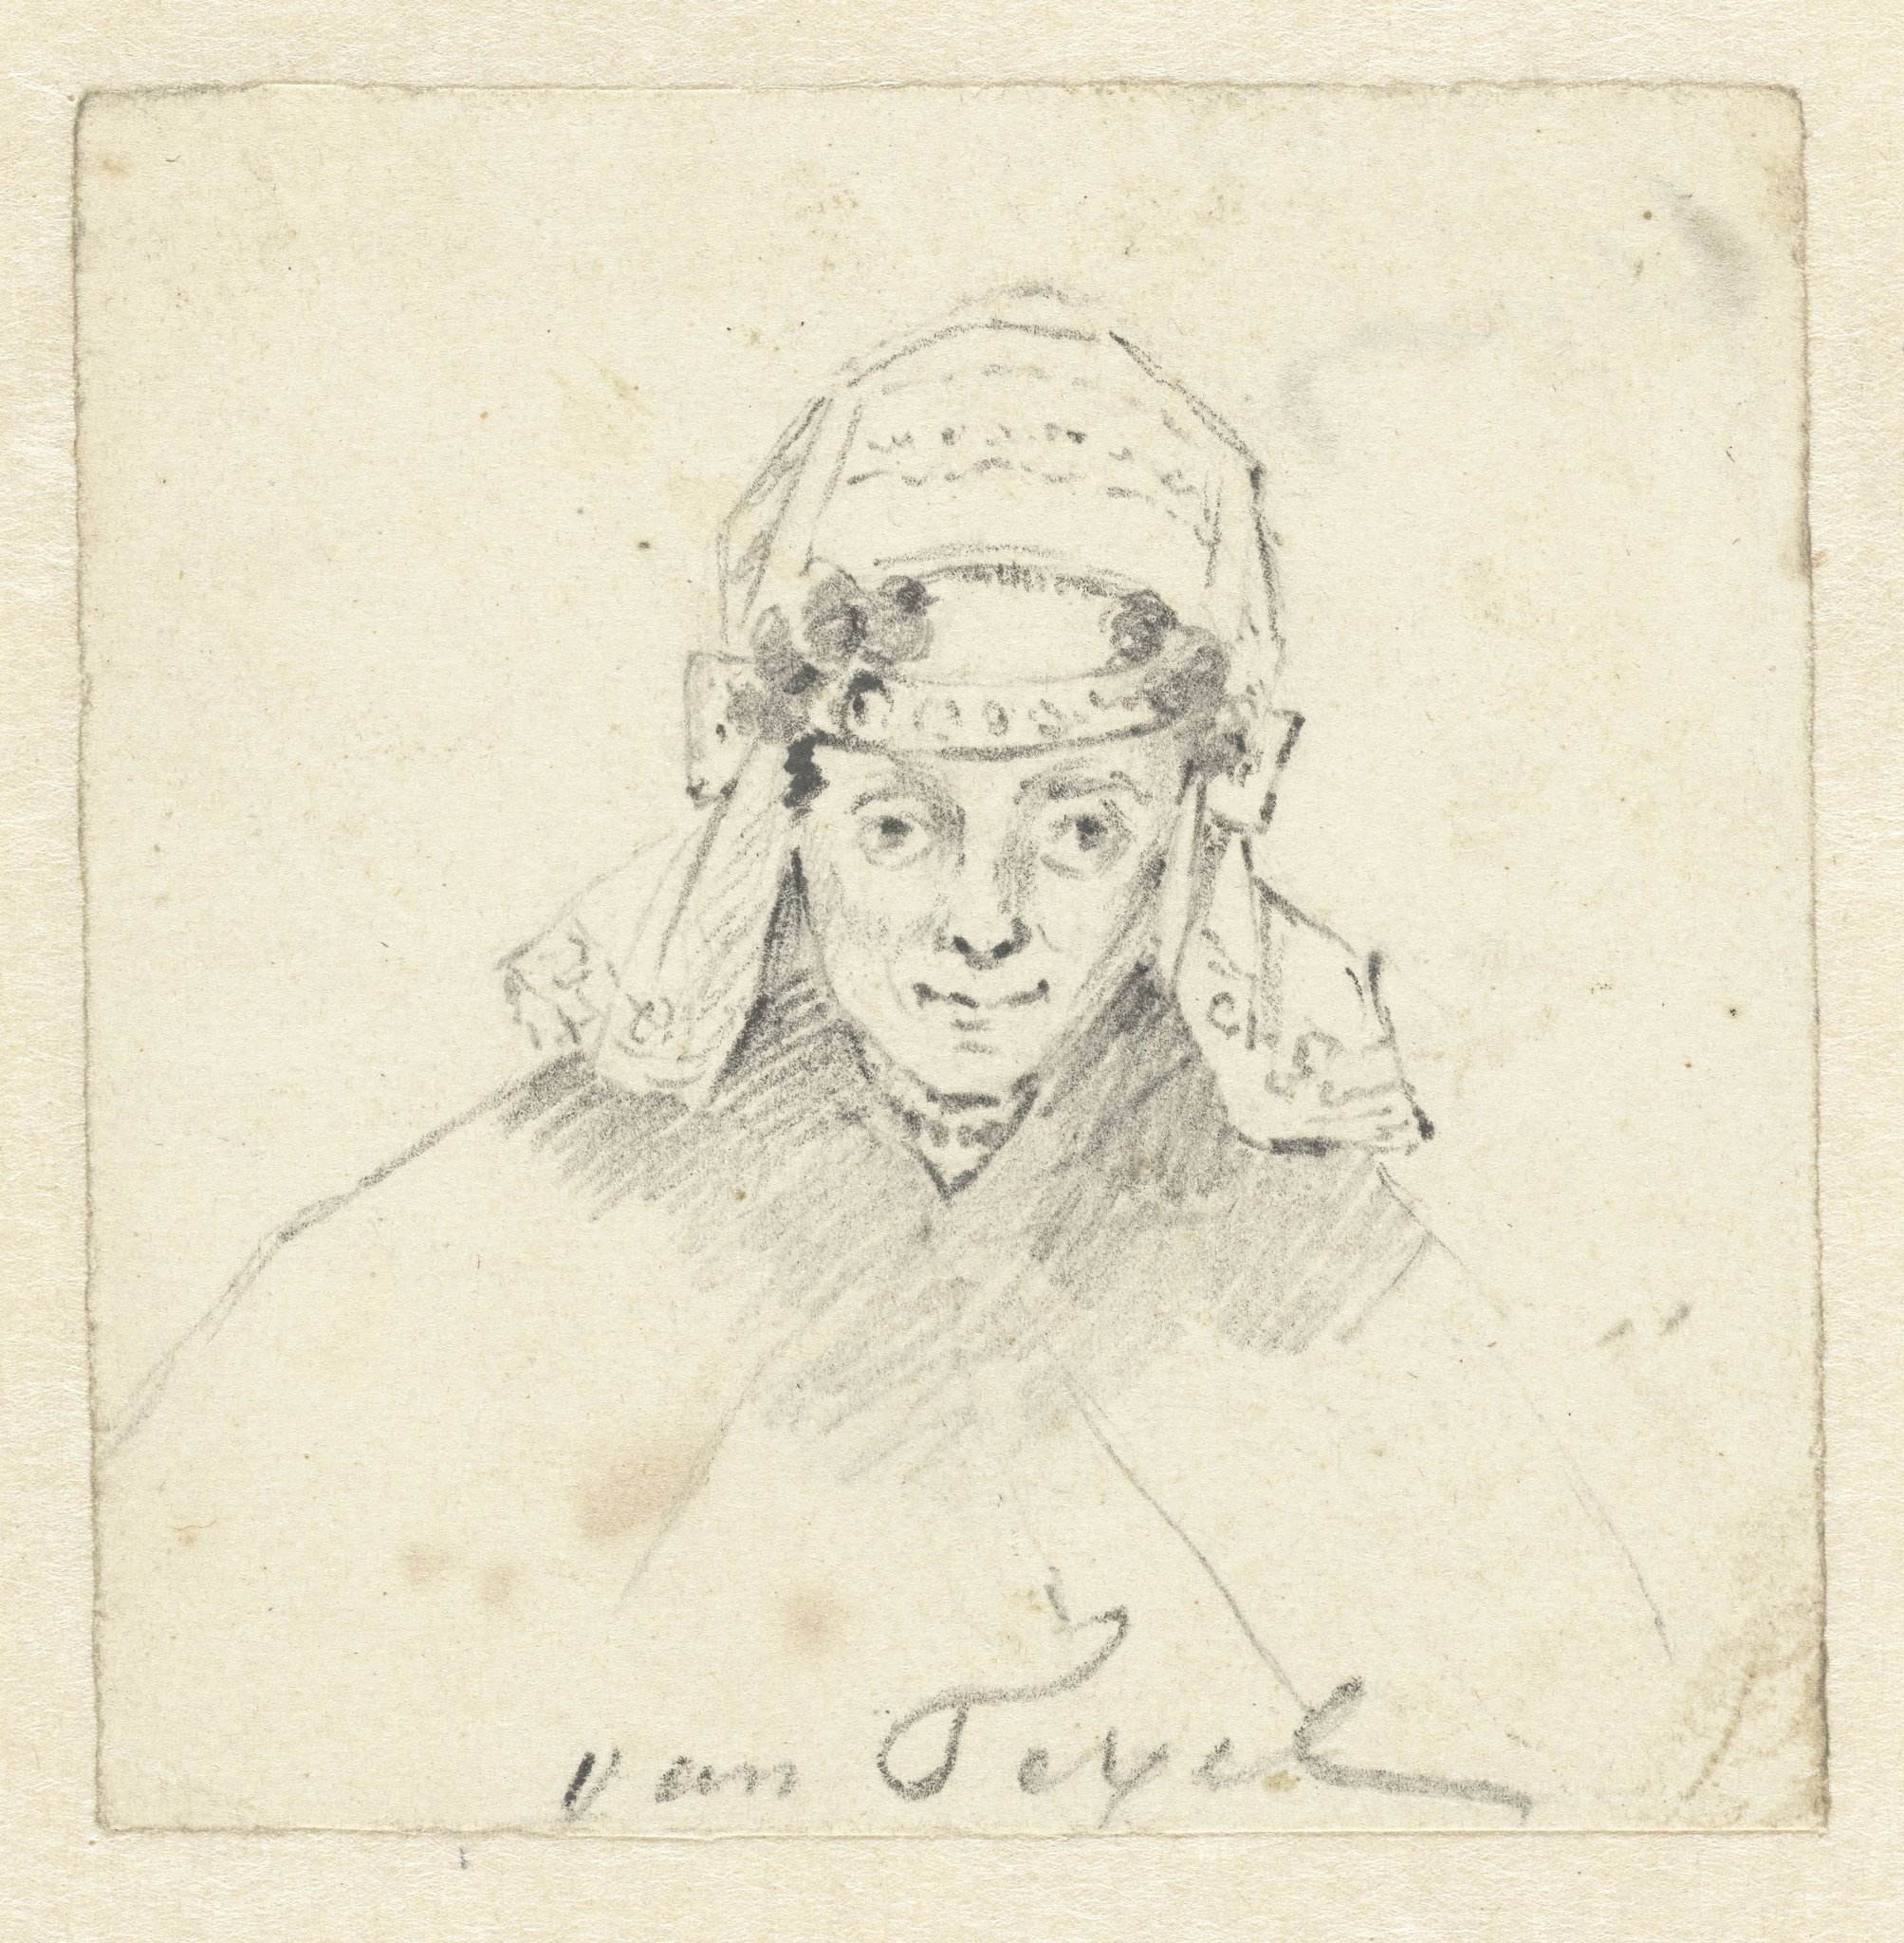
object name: drawing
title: Texelse vrouw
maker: jacob perkois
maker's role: draughtsman, print maker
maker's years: 1756-1804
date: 1766-1804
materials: paper, pencil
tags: texel